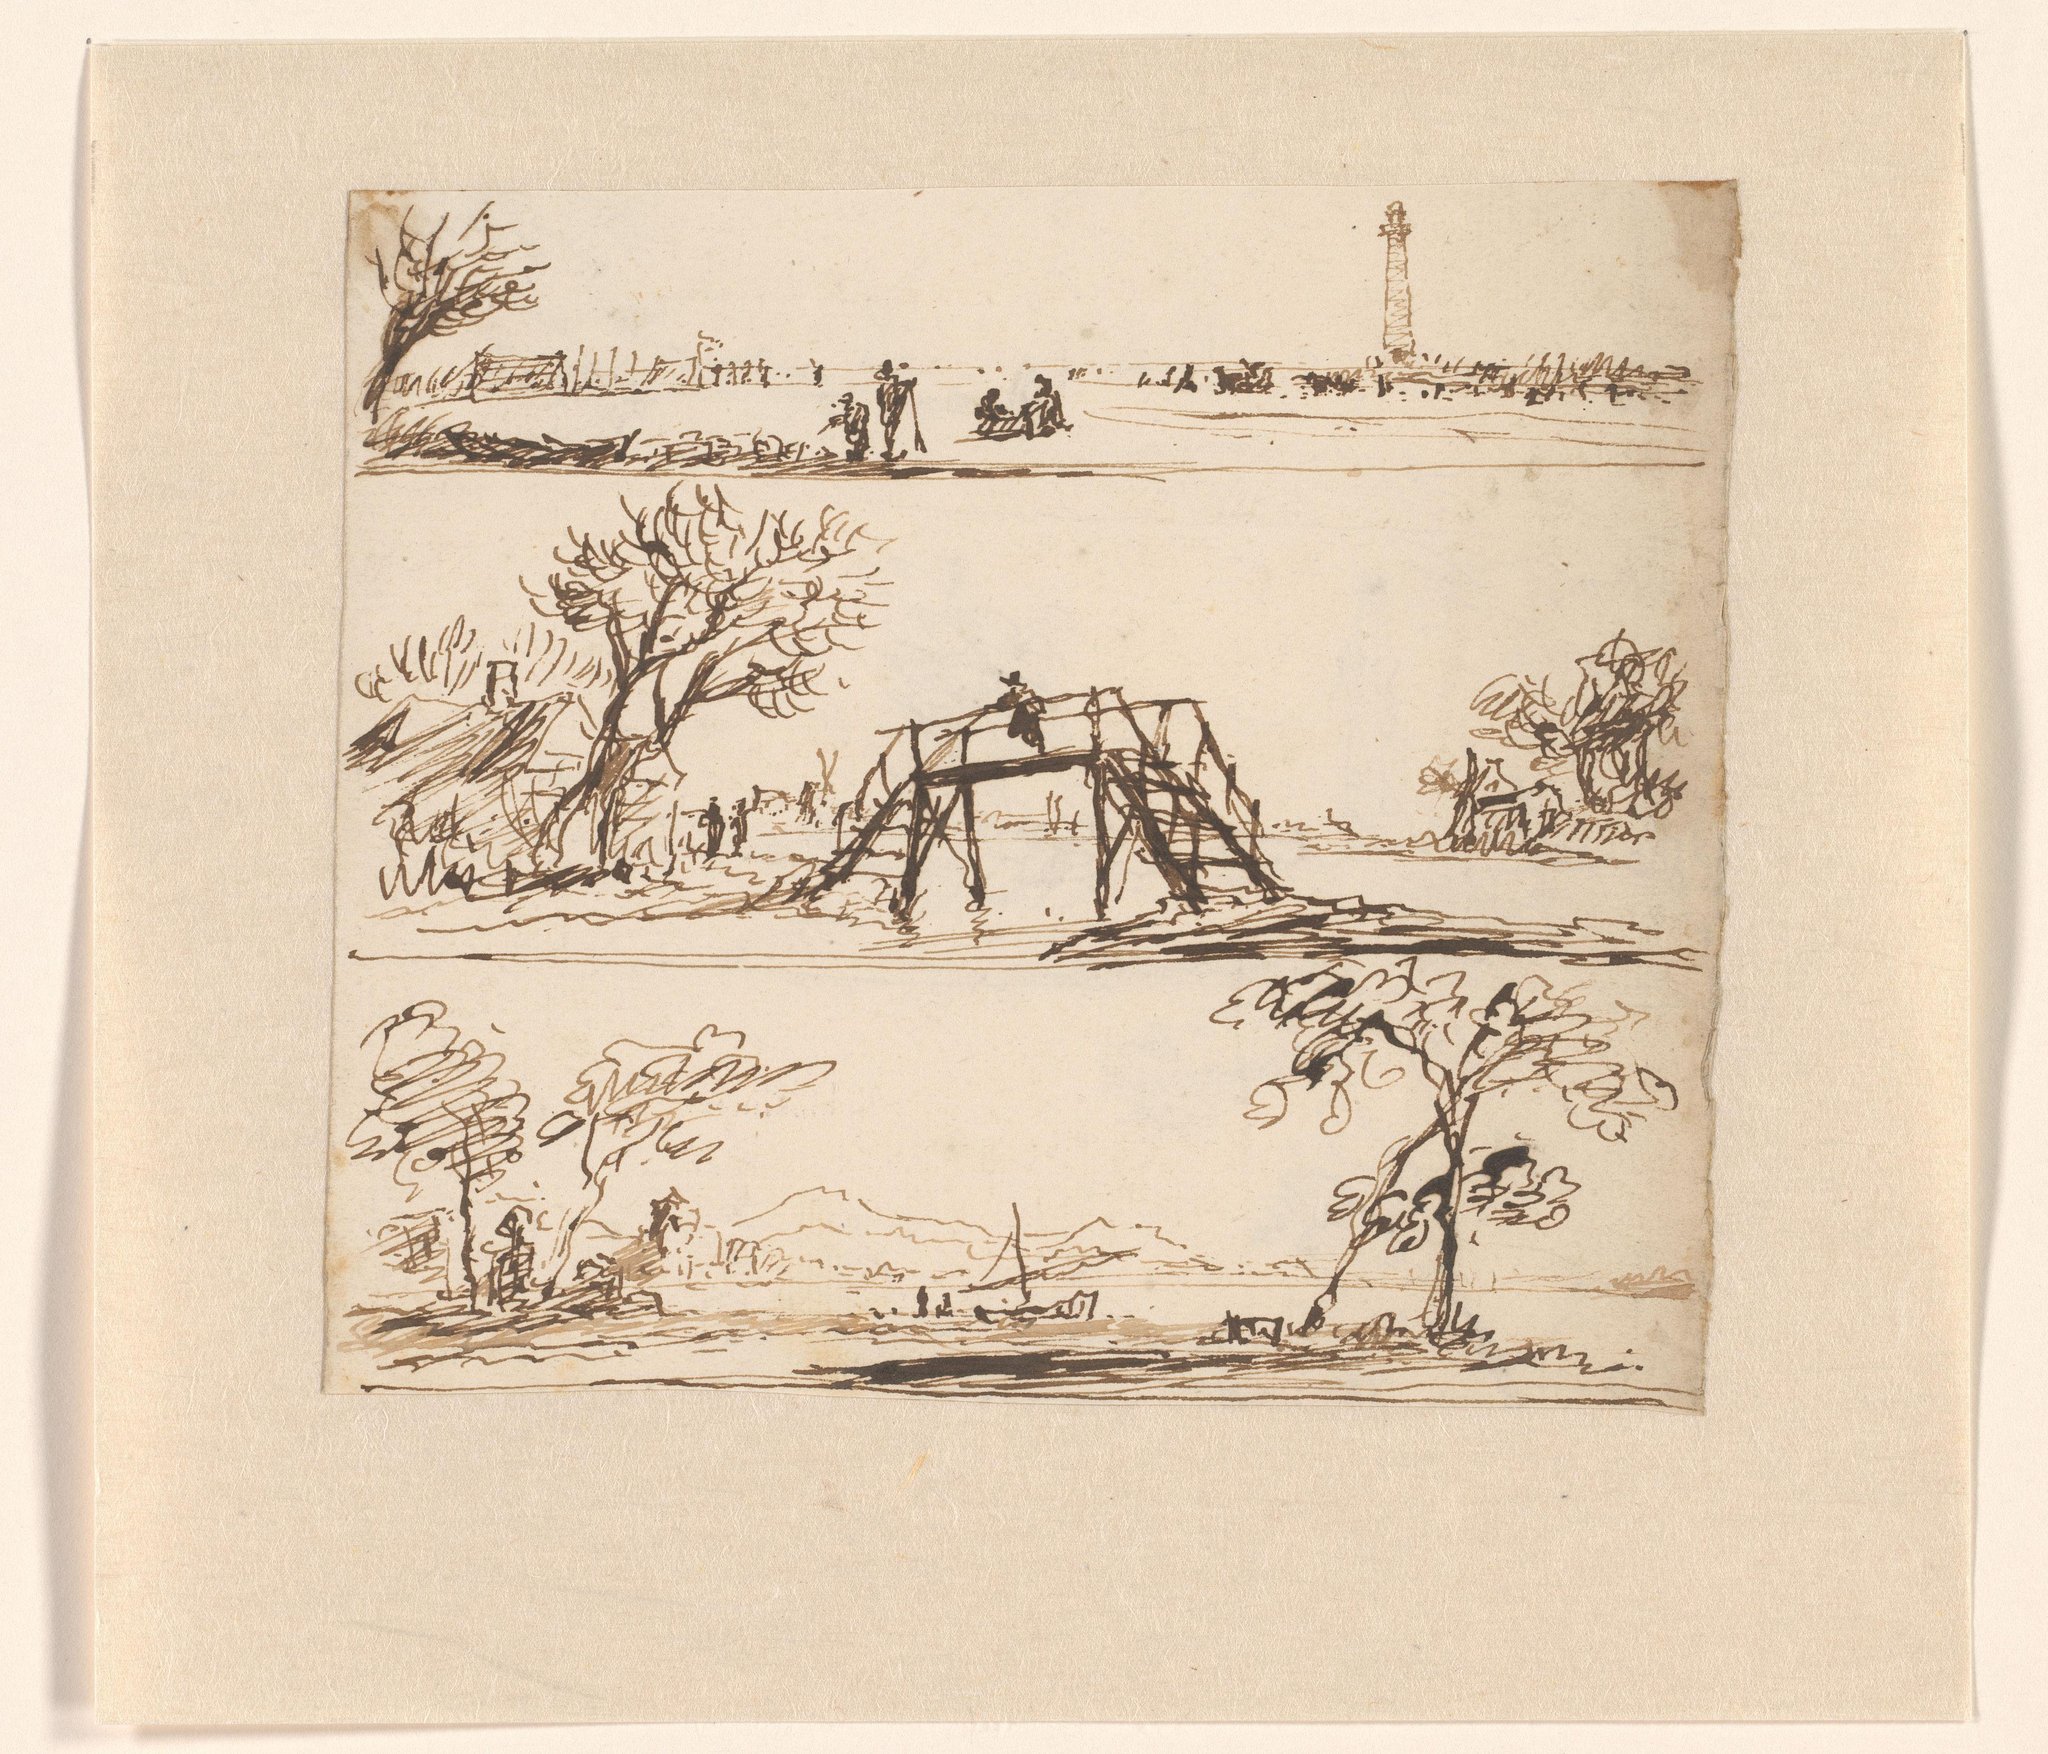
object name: drawing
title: Blad met drie voorstellingen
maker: hendrik spilman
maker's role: draughtsman, painter, print maker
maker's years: 1721-1784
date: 1731-1784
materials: ink, paper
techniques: pen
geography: northern netherlands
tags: lighthouse, lightship, skates (winter sports), sledge, sleigh (winter sports), river (+ landscape with figures, staffage), angling, landscape with bridge, viaduct or aqueduct (+ city(-scape) with figures, staffage)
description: Blad met drie voorstellingen. Boven: ijsprent in winterlandschap met vuurtoren. Midden: hengelaar vissend vanaf een brug. Onder: rivierlandschap.